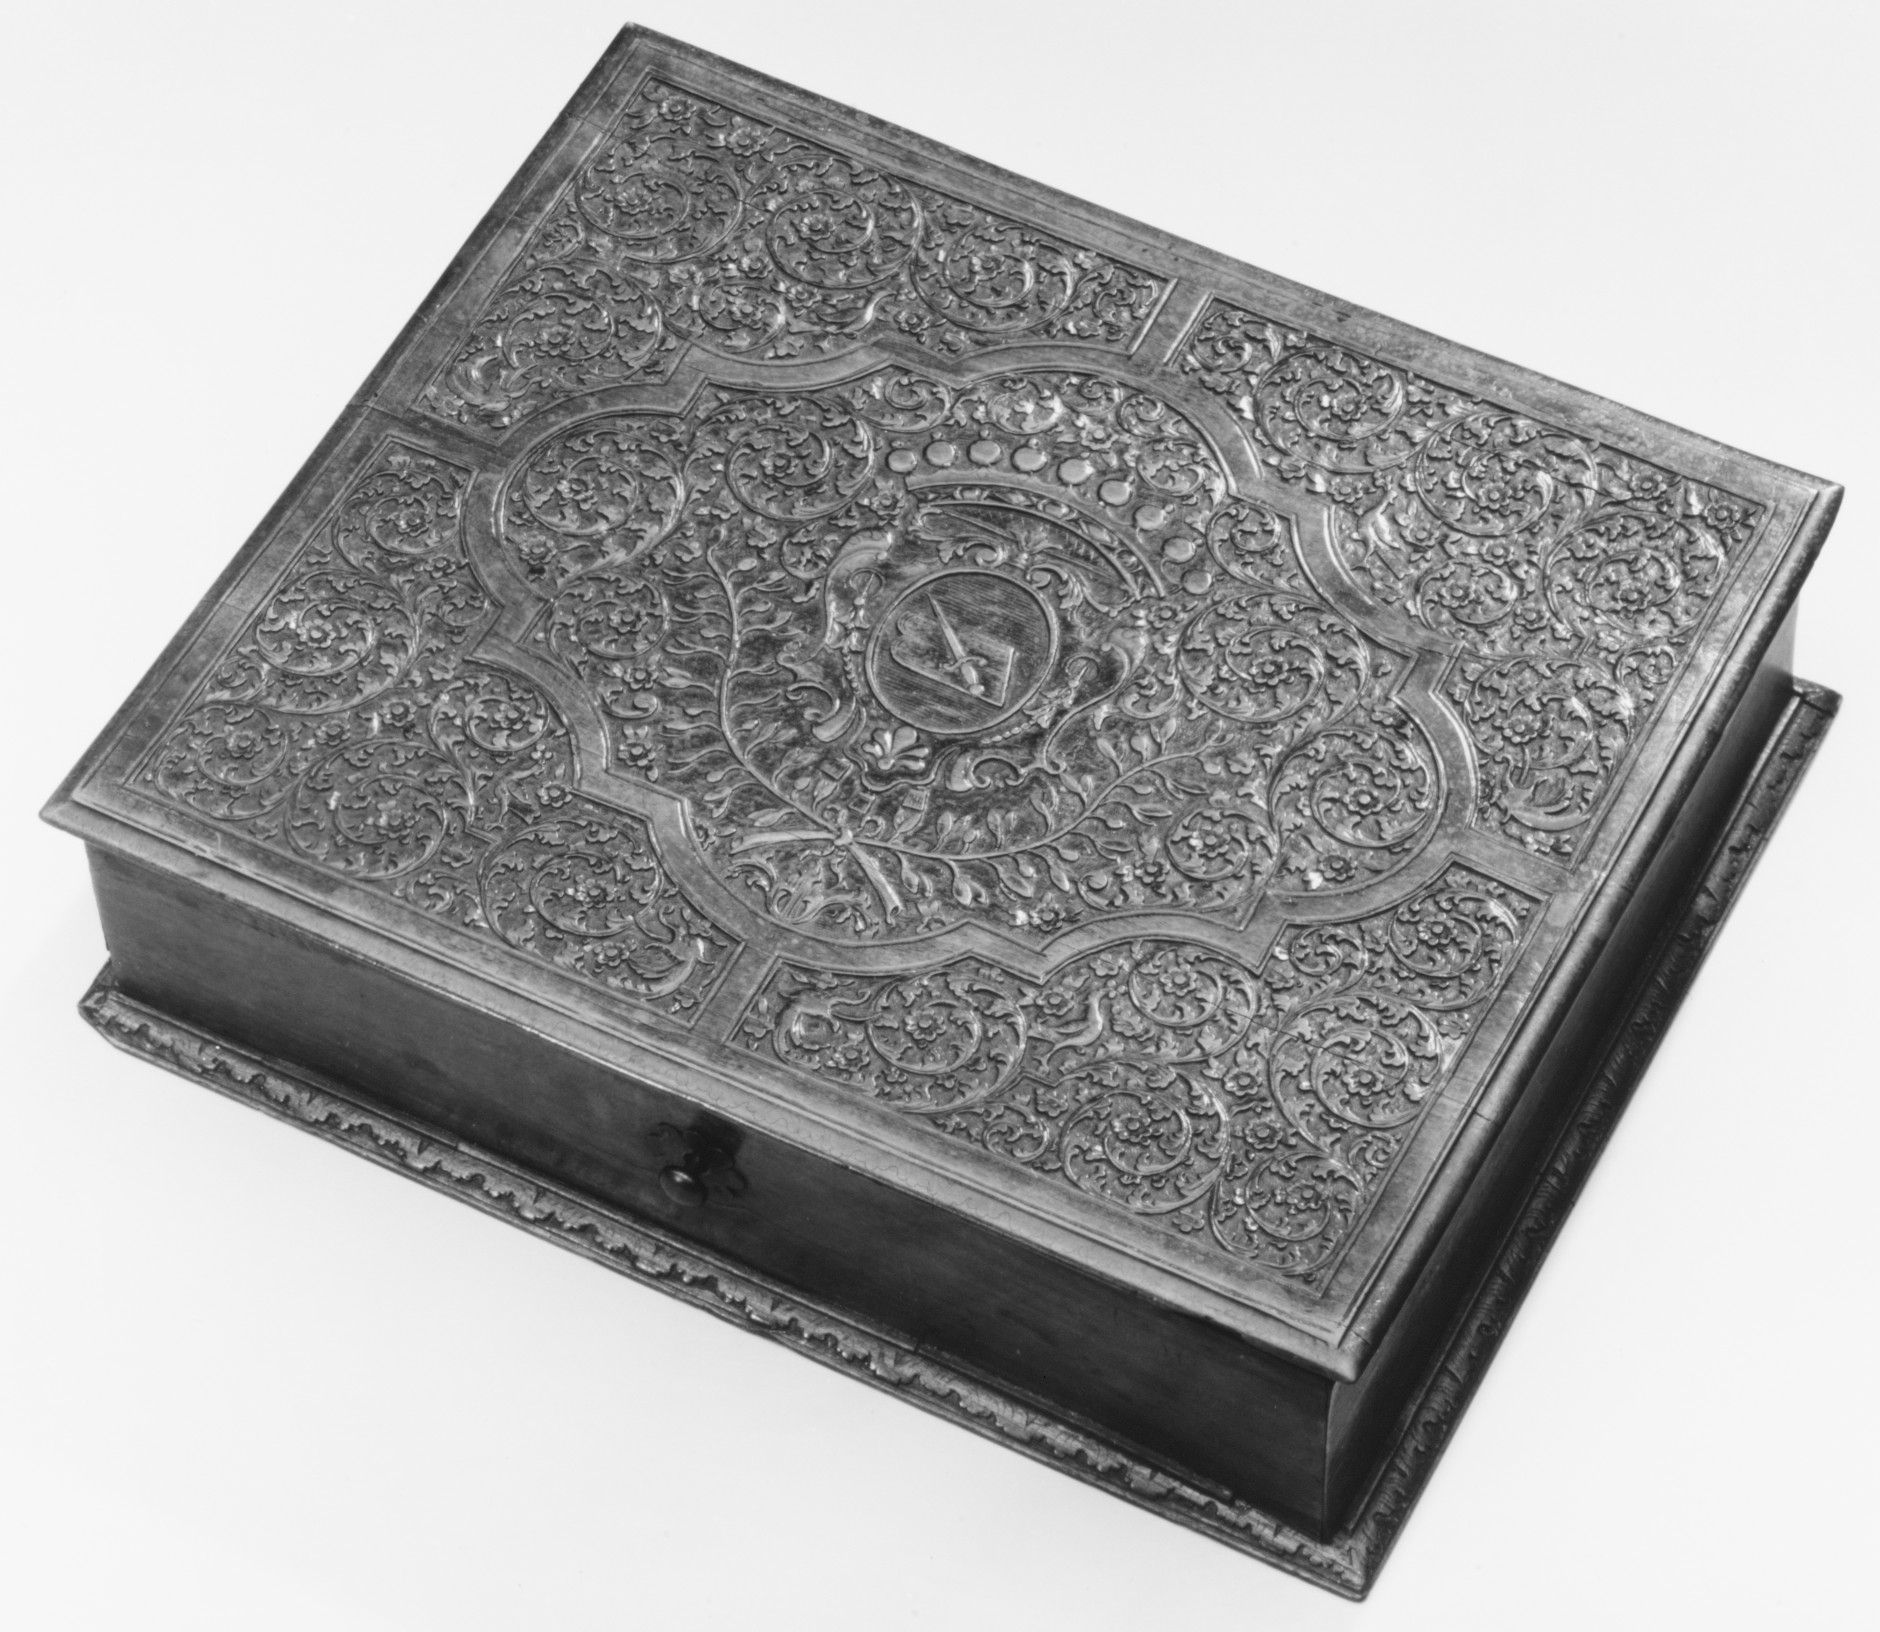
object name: box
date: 1667-1700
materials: wood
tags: flowers,leaves,insignia